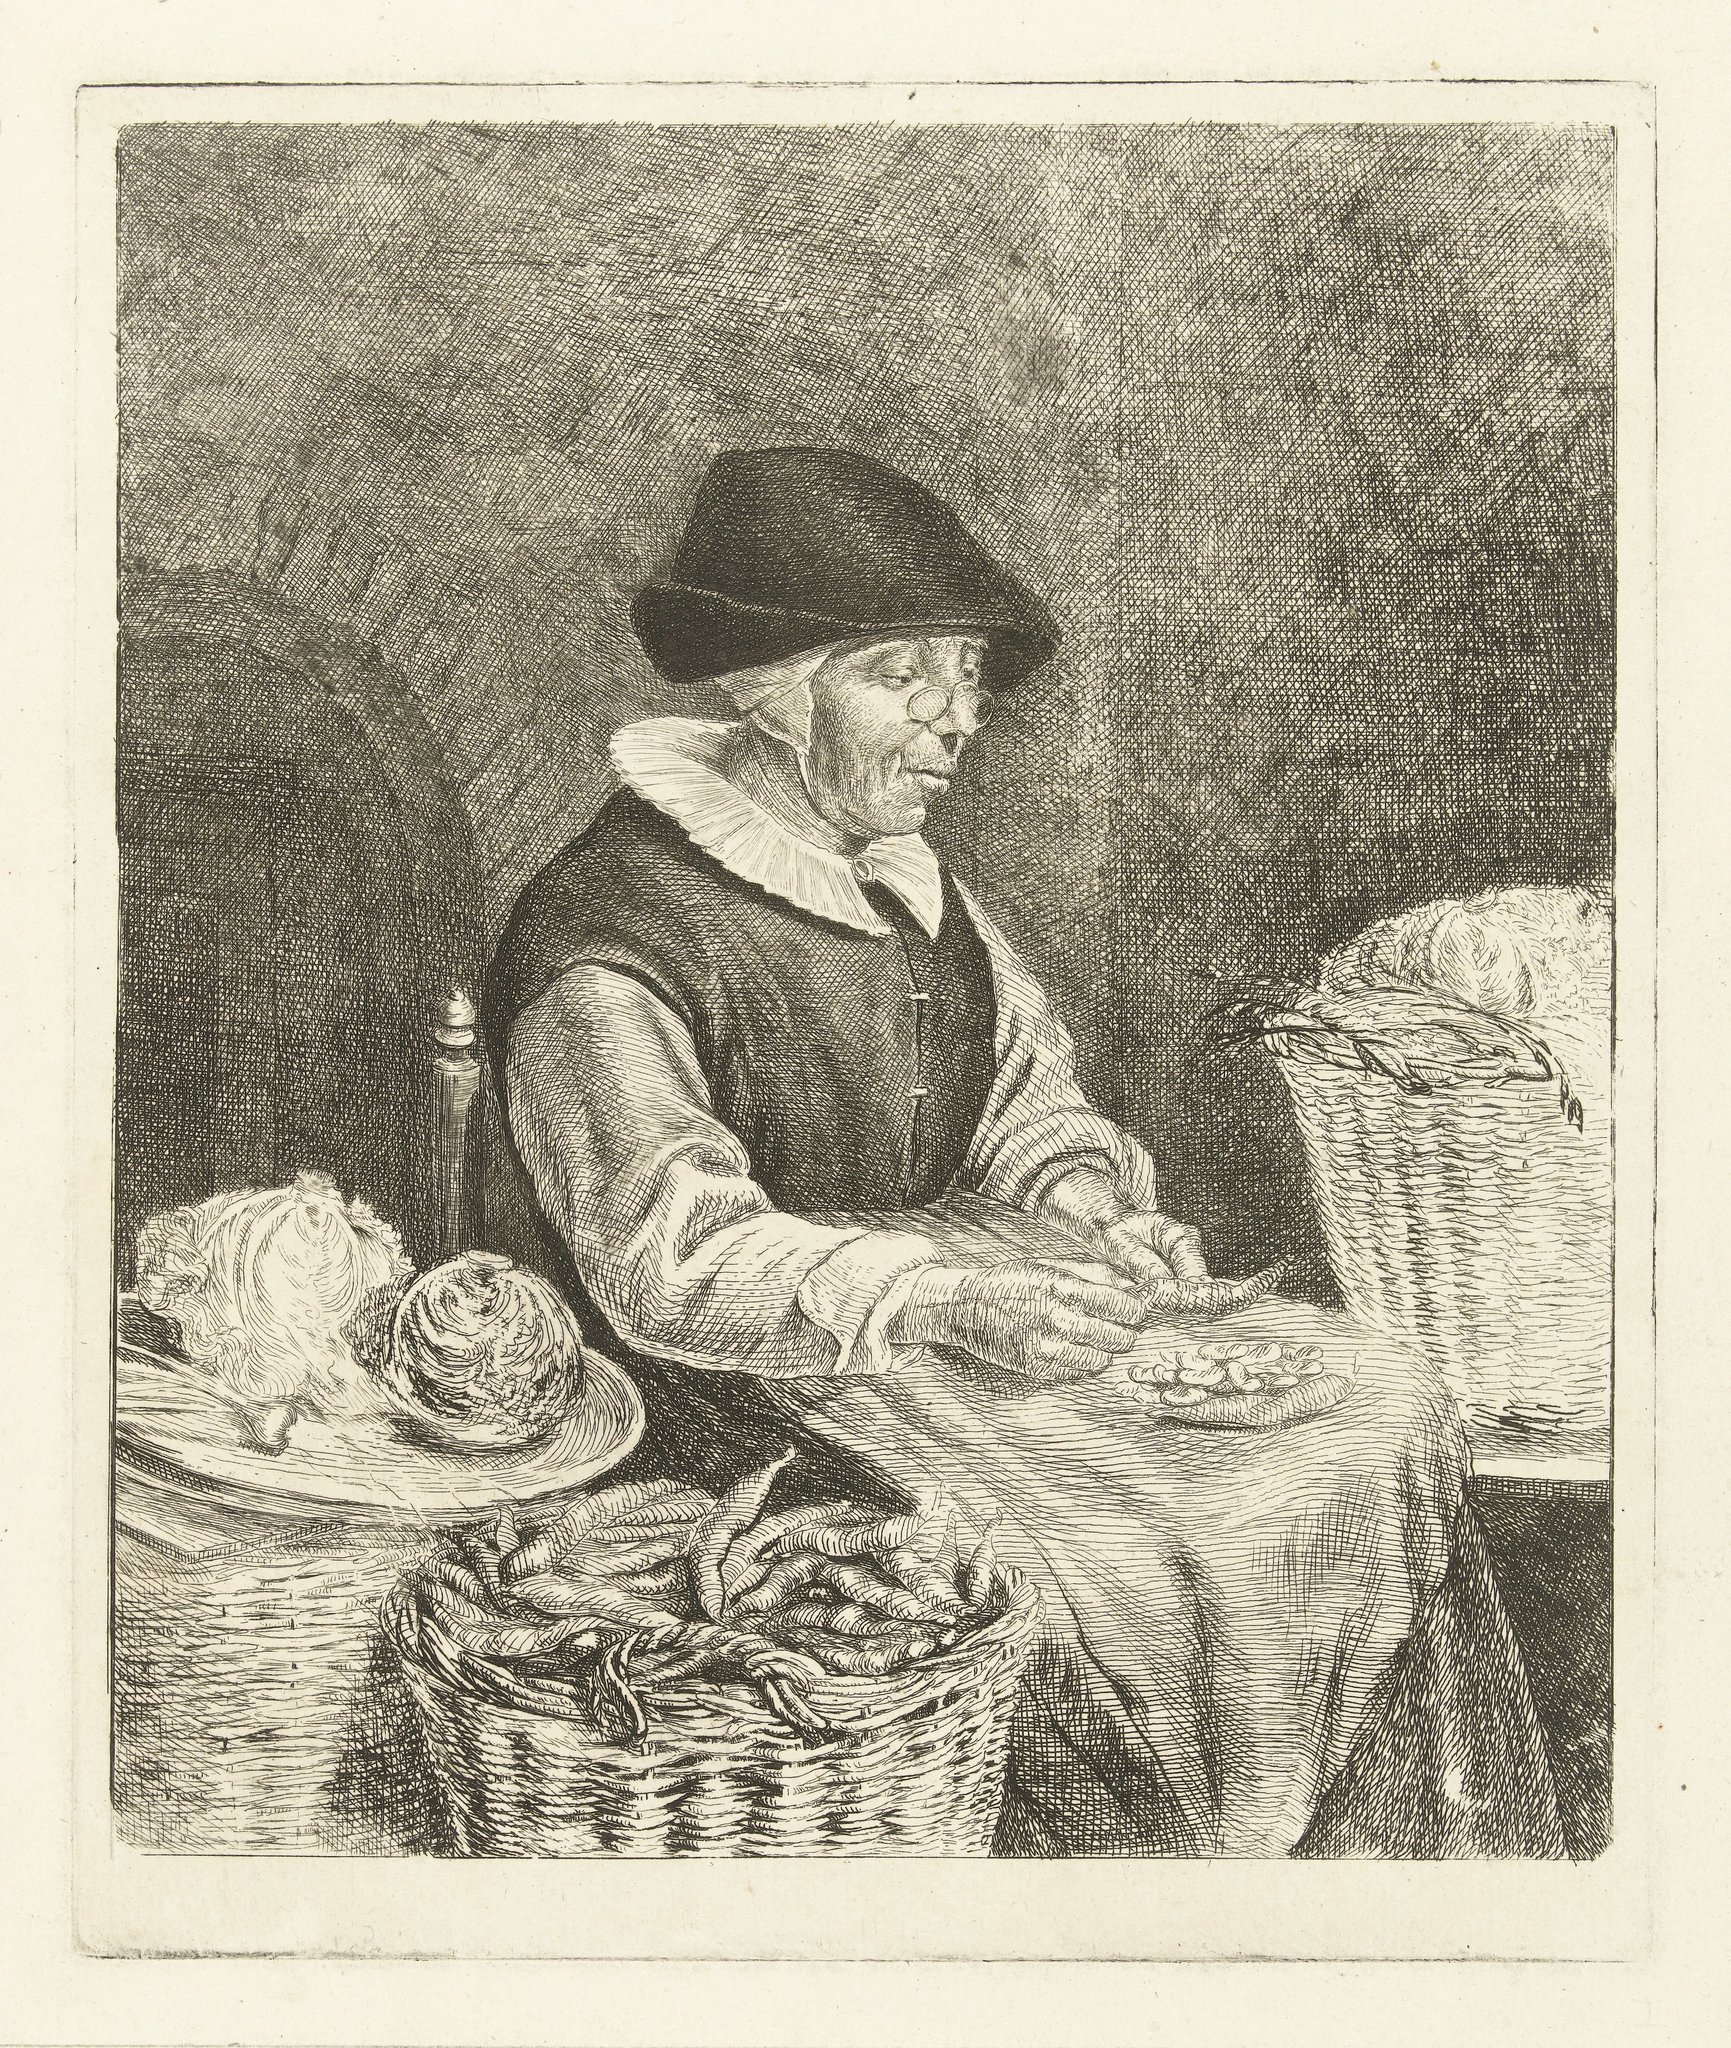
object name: print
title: Oude vrouw bij het boontjes doppen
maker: louis bernard coclers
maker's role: draughtsman, print maker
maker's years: 1741-1817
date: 1780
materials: paper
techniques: etching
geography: leiden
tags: eyeglasses, spectacles, cleaning vegetables, cleaning fruit, e.g. peeling, fruits: beans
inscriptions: collector's mark: Lugt 2228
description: Een oude vrouw zit in de keuken op een stoel en dopt bonen. De boontjes doet ze in haar schort. Naast haar staan manden met kolen, lof en bonen. De vrouw draagt een donkere hoed en een knijpbril.